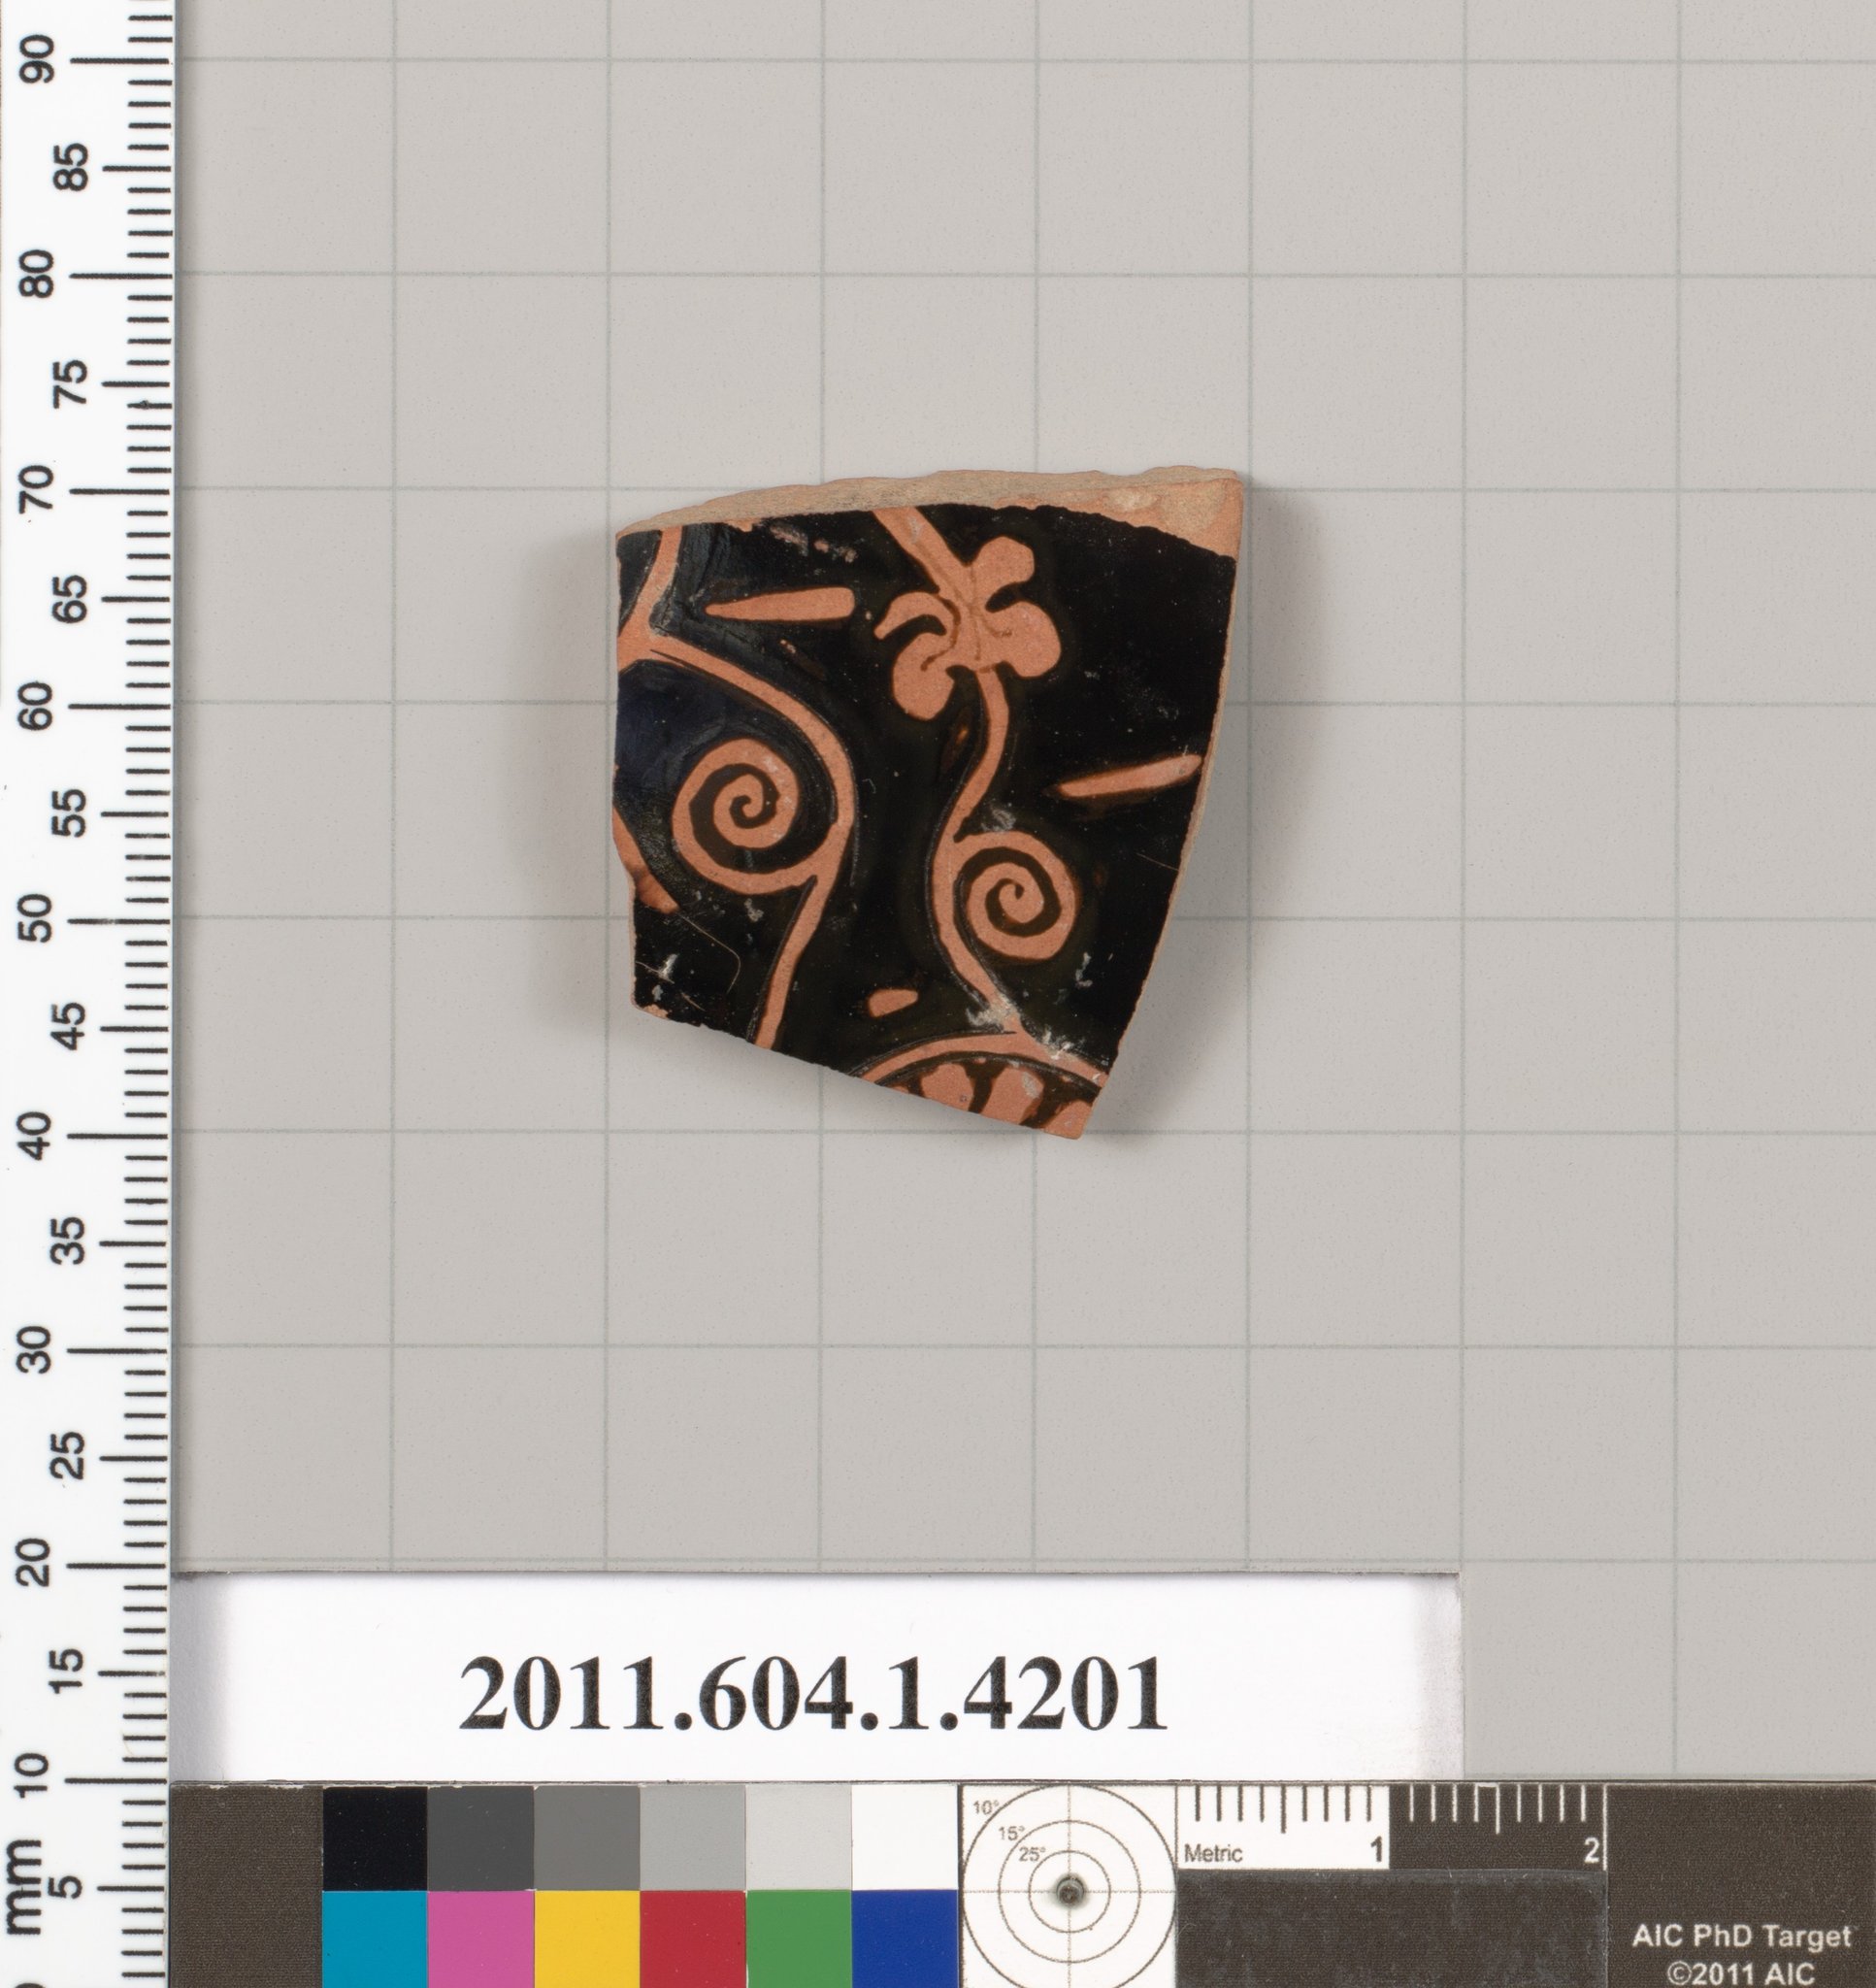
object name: kylix fragment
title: Terracotta fragment of a kylix (drinking cup)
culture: greek, attic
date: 520-500 BCE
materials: terracotta